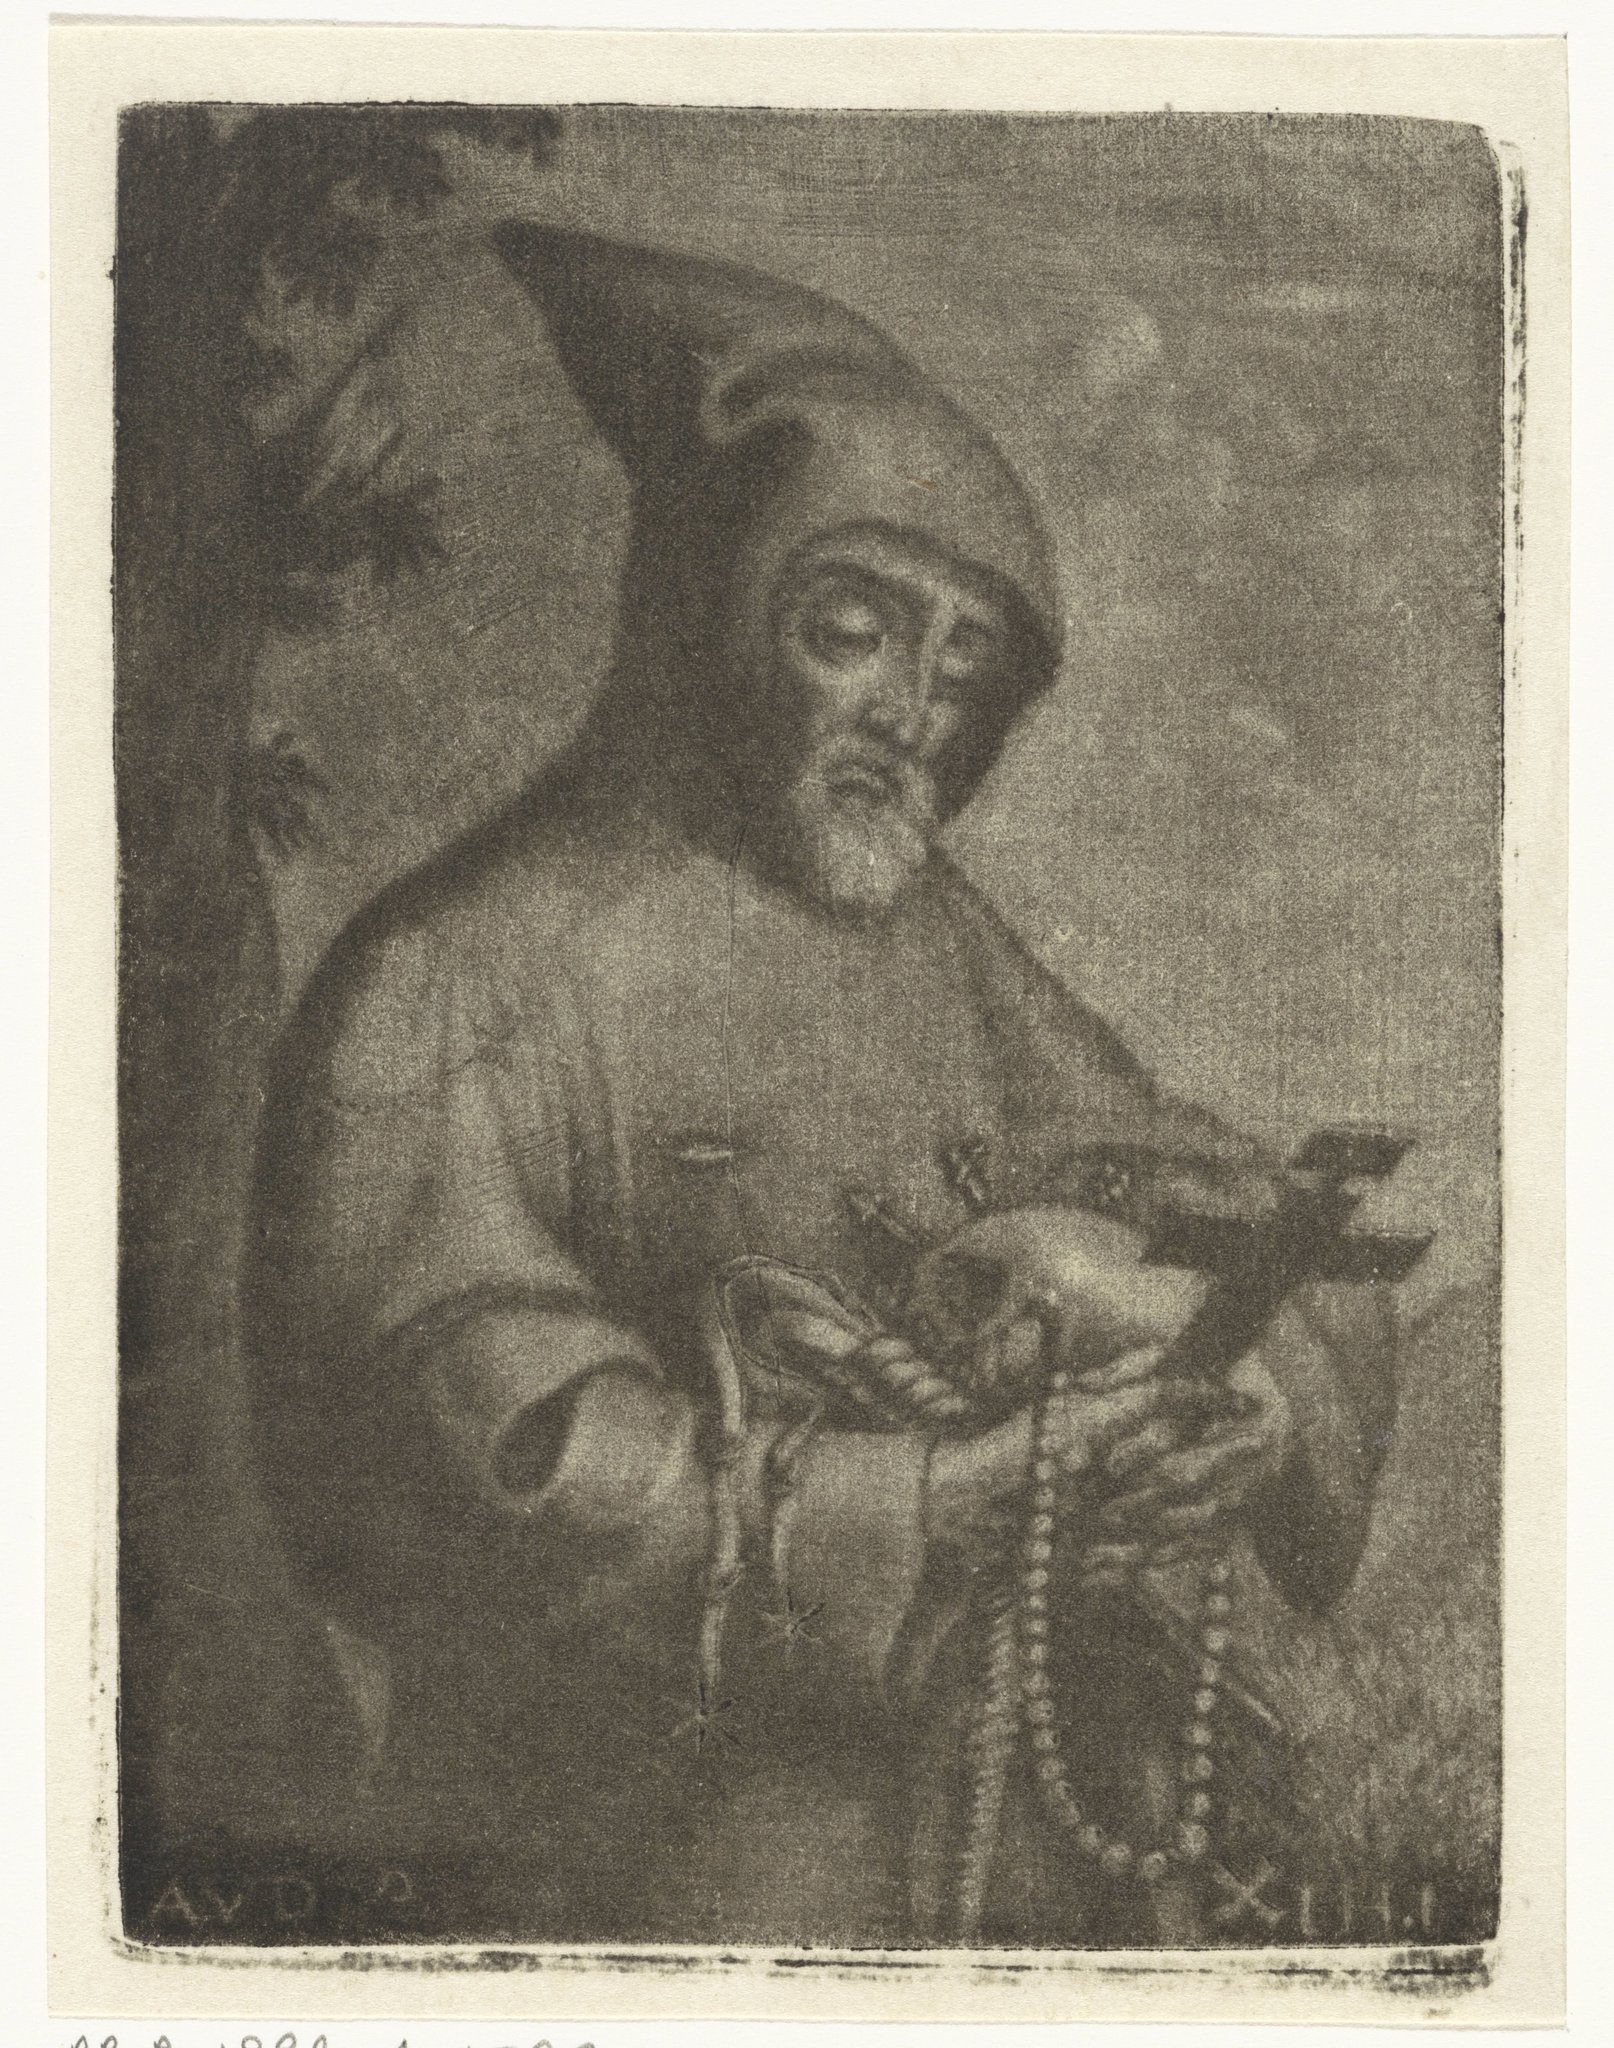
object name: print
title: Monnik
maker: jan van der bruggen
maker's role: draughtsman, print maker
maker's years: 1649-1709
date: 1659-1740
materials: paper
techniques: engraving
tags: (human) skull, monk(s), friar(s)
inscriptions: collector's mark: Lugt 2228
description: Een monnik met een kap op het hoofd draagt in de armen een doodshoofd, een kruis en een rozenkrans.